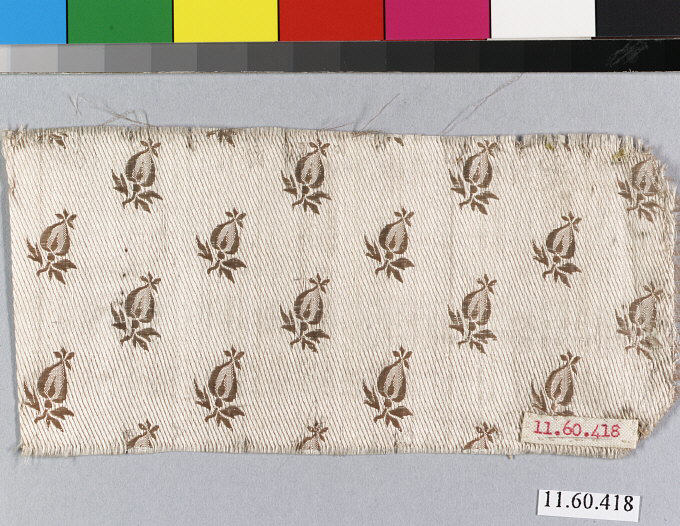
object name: fragment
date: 1801-1900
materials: silk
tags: flowers,leaves